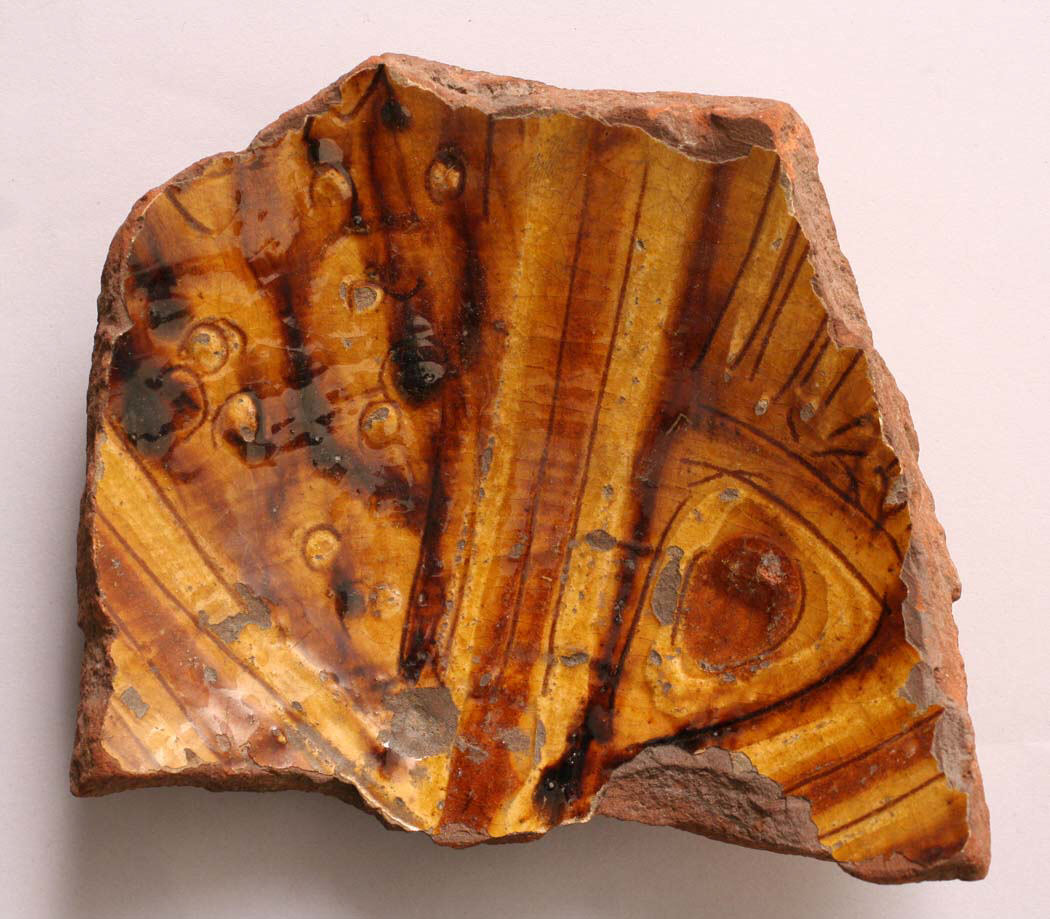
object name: ceramic fragment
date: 1301-1500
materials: earthenware, glaze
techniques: coloring, incising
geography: egypt